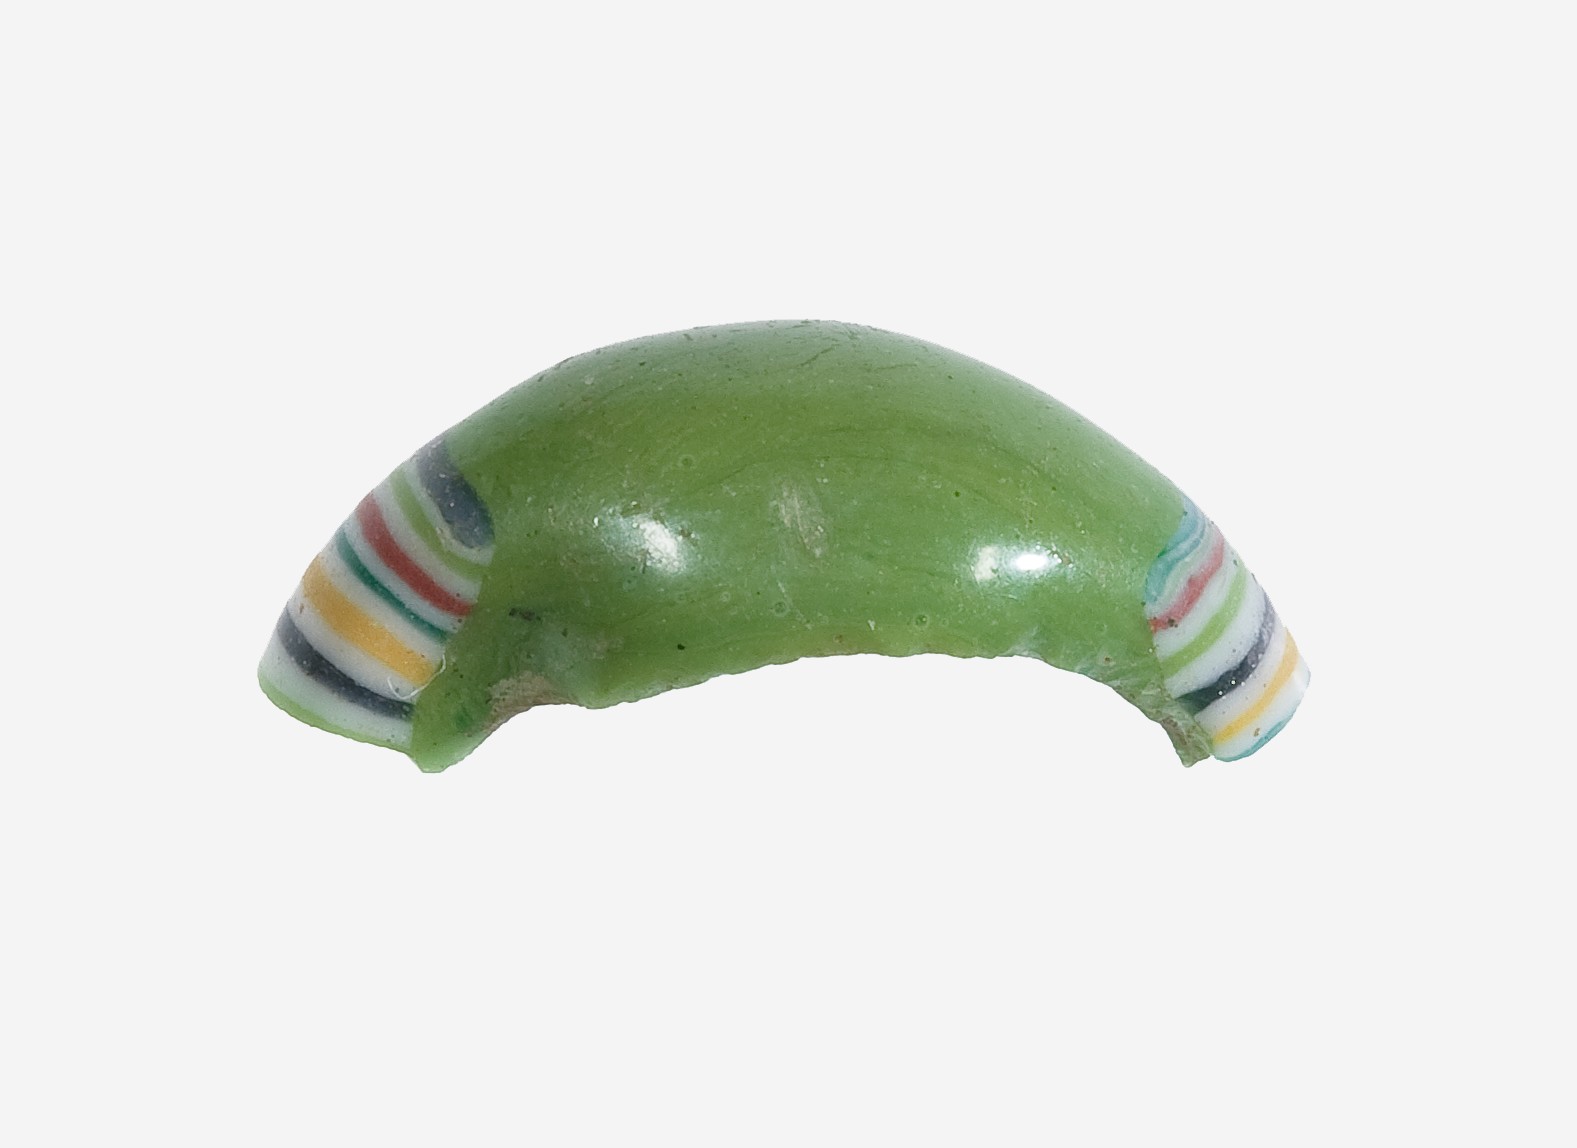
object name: ring fragment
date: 1390-1352 BCE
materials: glass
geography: egypt